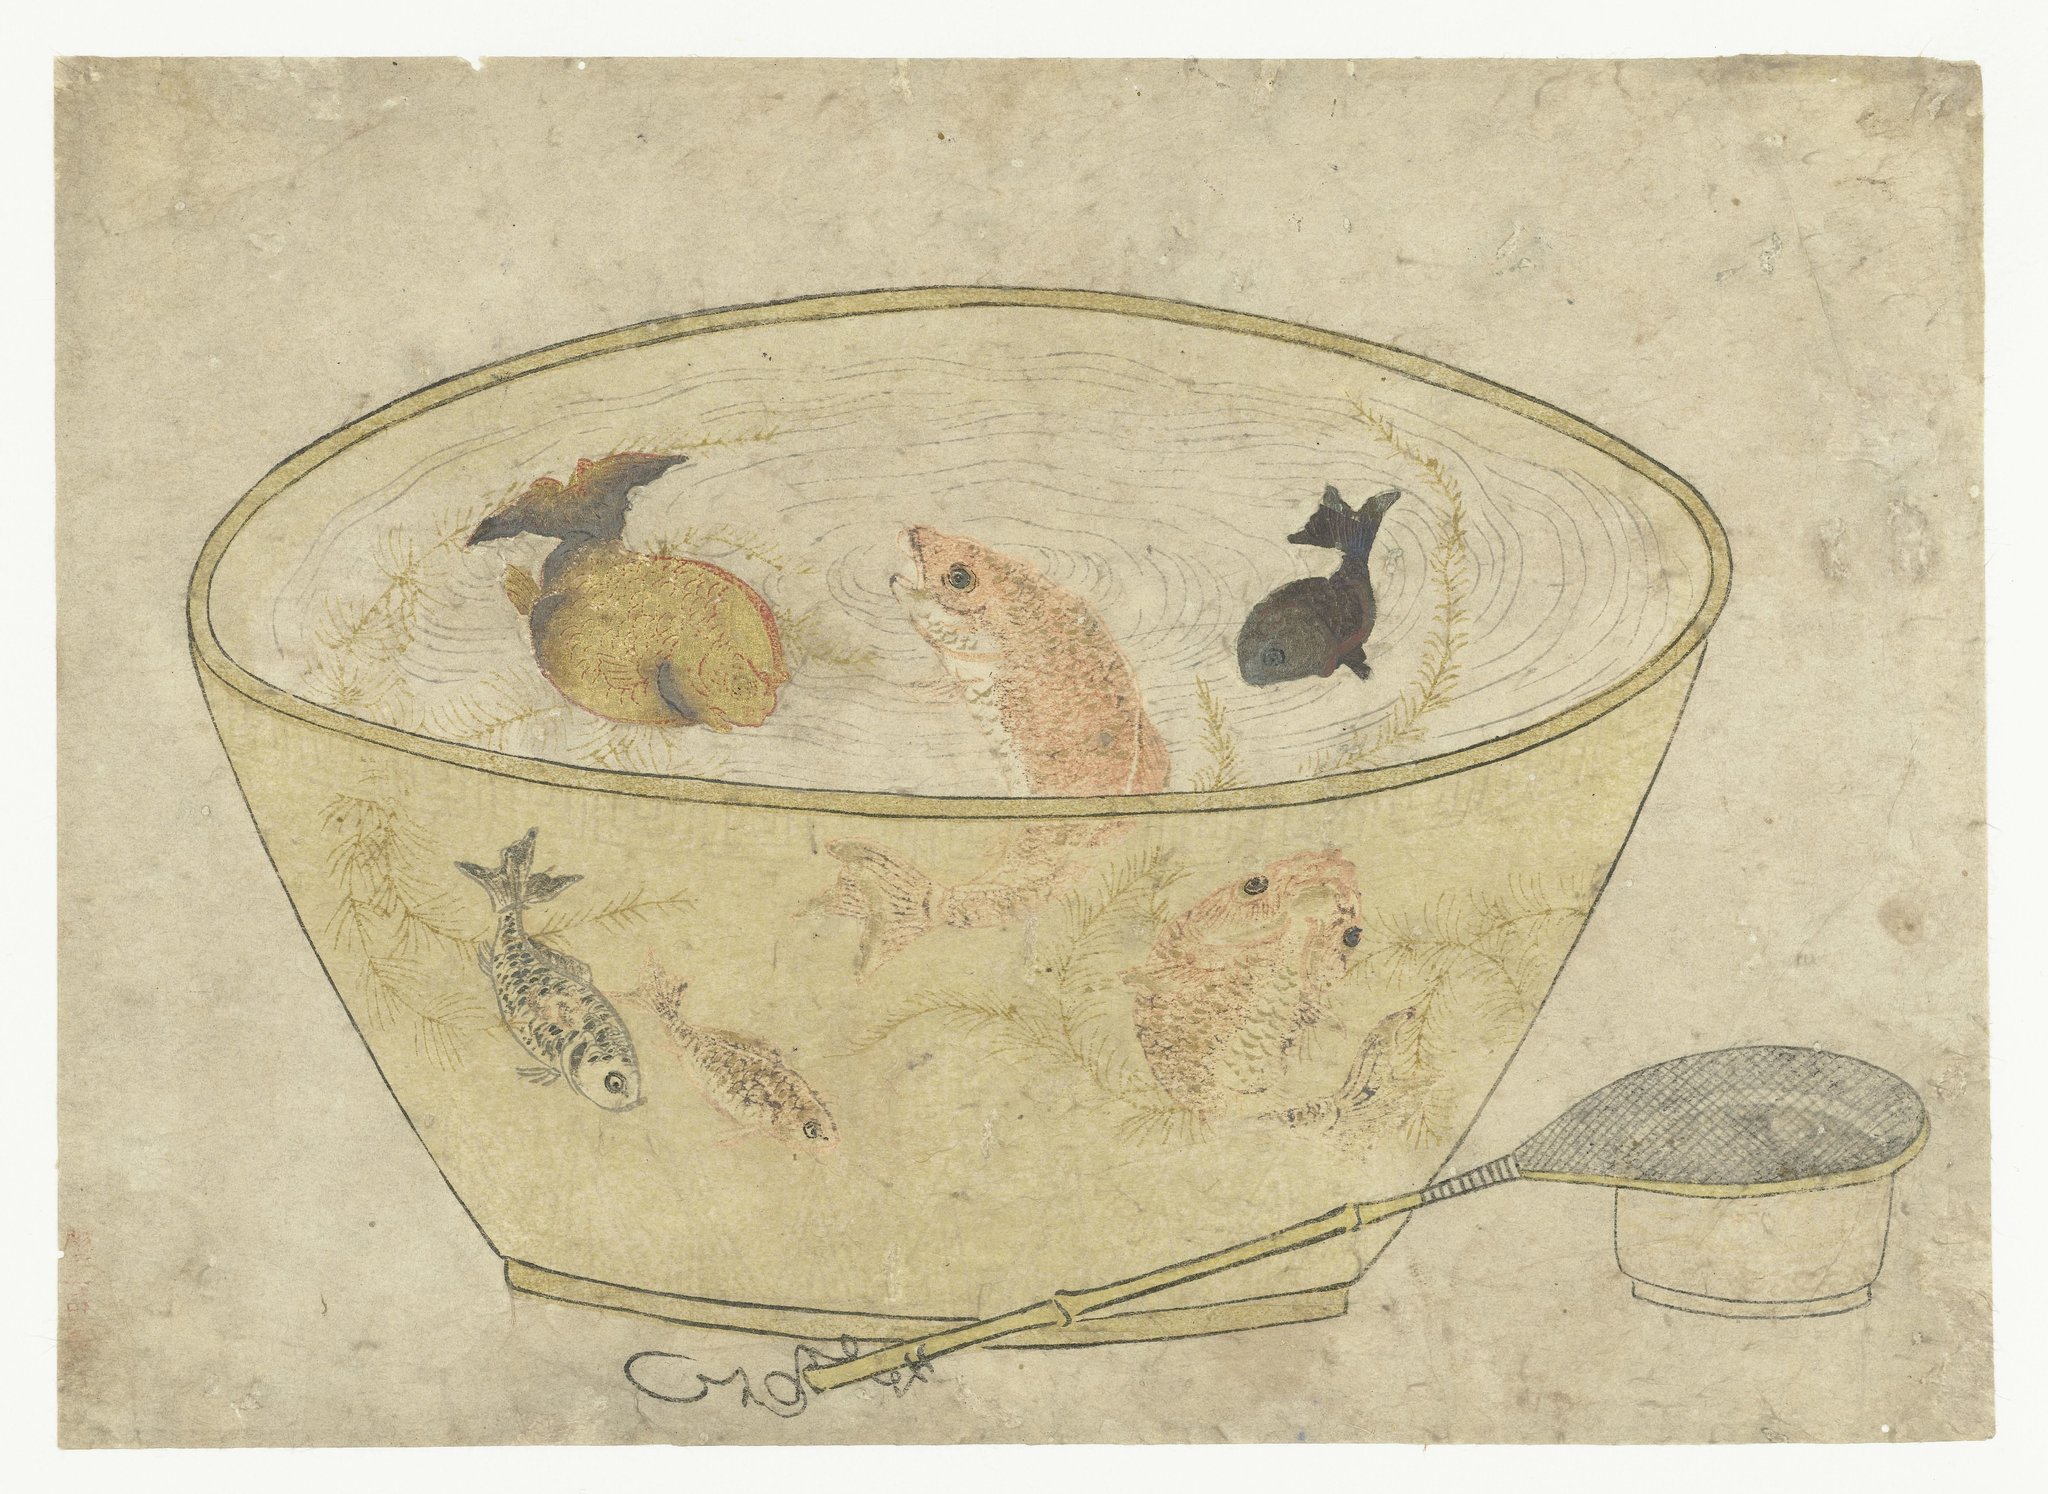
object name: print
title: Goudvissen in kom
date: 1765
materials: paper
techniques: woodcut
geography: japan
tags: fishes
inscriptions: collector's mark, verso, stamped: Lugt 2228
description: Glazen kom met zes vissen. Rechtsvoor een schepnet. De draad rondom het handvat van het schepnet verwijst naar het publicatiejaar, 1765.